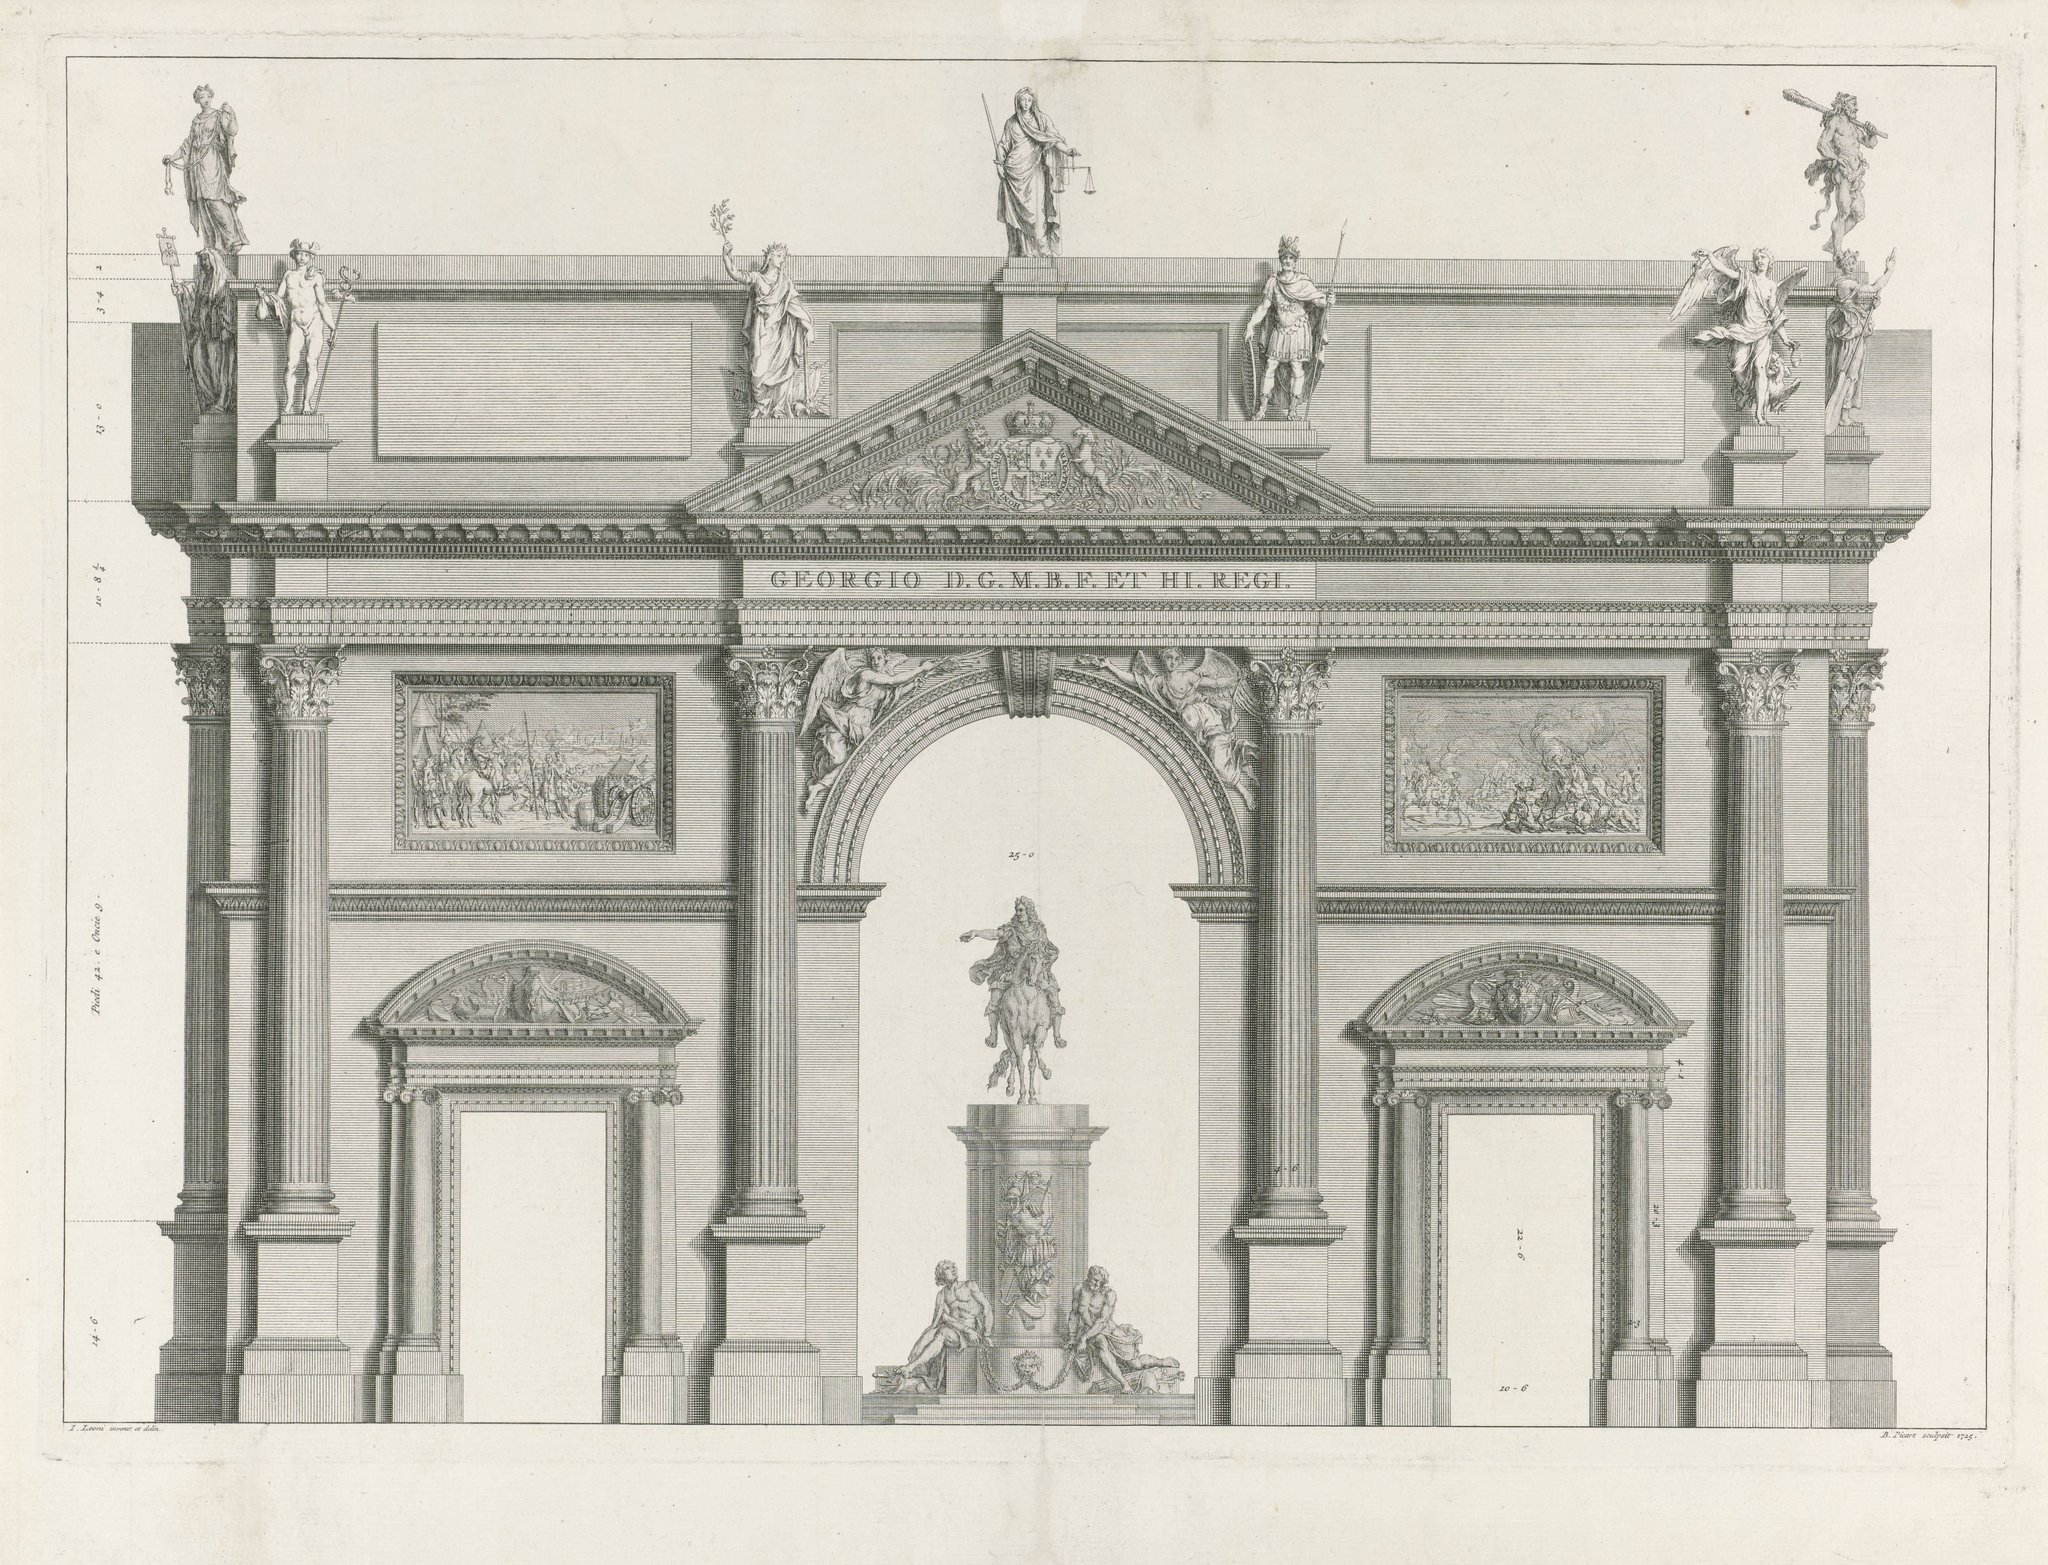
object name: print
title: De triomfboog voor George I van Groot-Brittannië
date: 1725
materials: paper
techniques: engraving, etching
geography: amsterdam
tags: george i (koning van groot-brittannië en ierland), virtues of the ruler, triumphal arch, battle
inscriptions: collector's mark: Lugt 2228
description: De triomfboog opgesteld voor koning George I, koning van Groot-Brittannië, met de daarbij horende afmetingen. De boog wordt bekroond door standbeelden van personificaties van deugden. Onder de boog een ruiterstandbeeld van de koning.